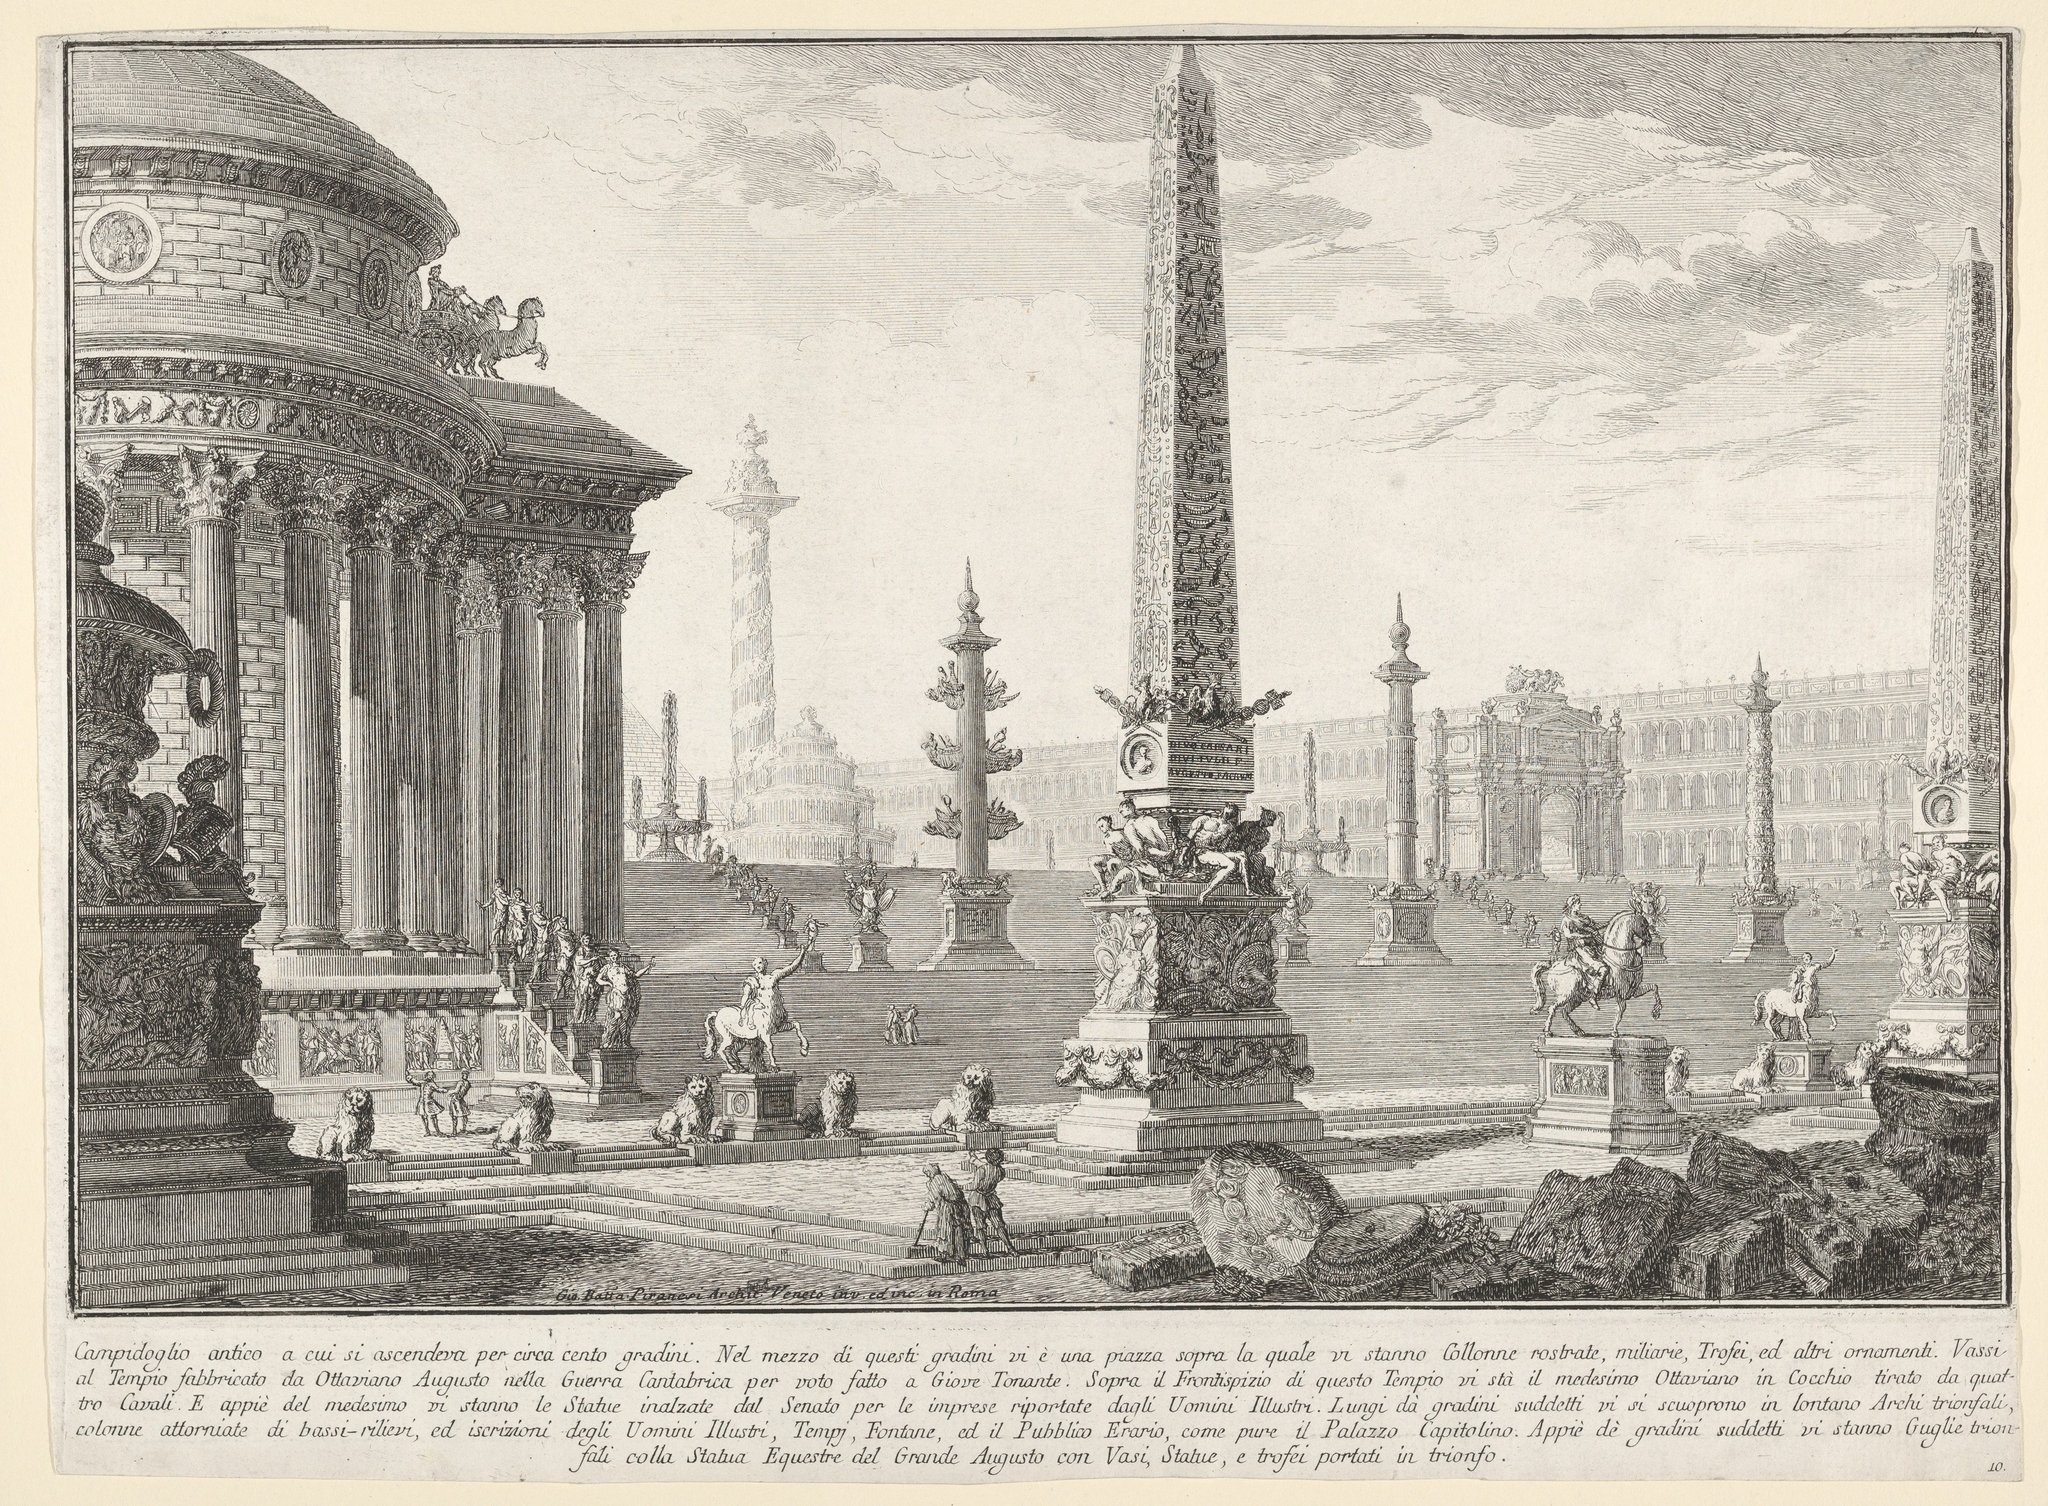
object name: print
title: Plate 10: The ancient Capitol ascended by approximately one hundred steps [...] (Campidoglio antico a cui si ascendeva per circa cento gradini [...]), from "Part one of architecture and perspectives: drawn and etched by Gio. Batt'a Piranesi, Venetian Architect: dedicated to Nicola Giobbe" (Prima parte di Architetture, e prospettive inventate, ed incise da Gio. Batt'a Piranesi Architetto Veneziano dedicate al Sig. Nicola Giobbe)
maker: giovanni battista piranesi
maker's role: artist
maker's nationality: italian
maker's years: 1720-1778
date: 1743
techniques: etching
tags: architecture,obelisks,centaurs,horses